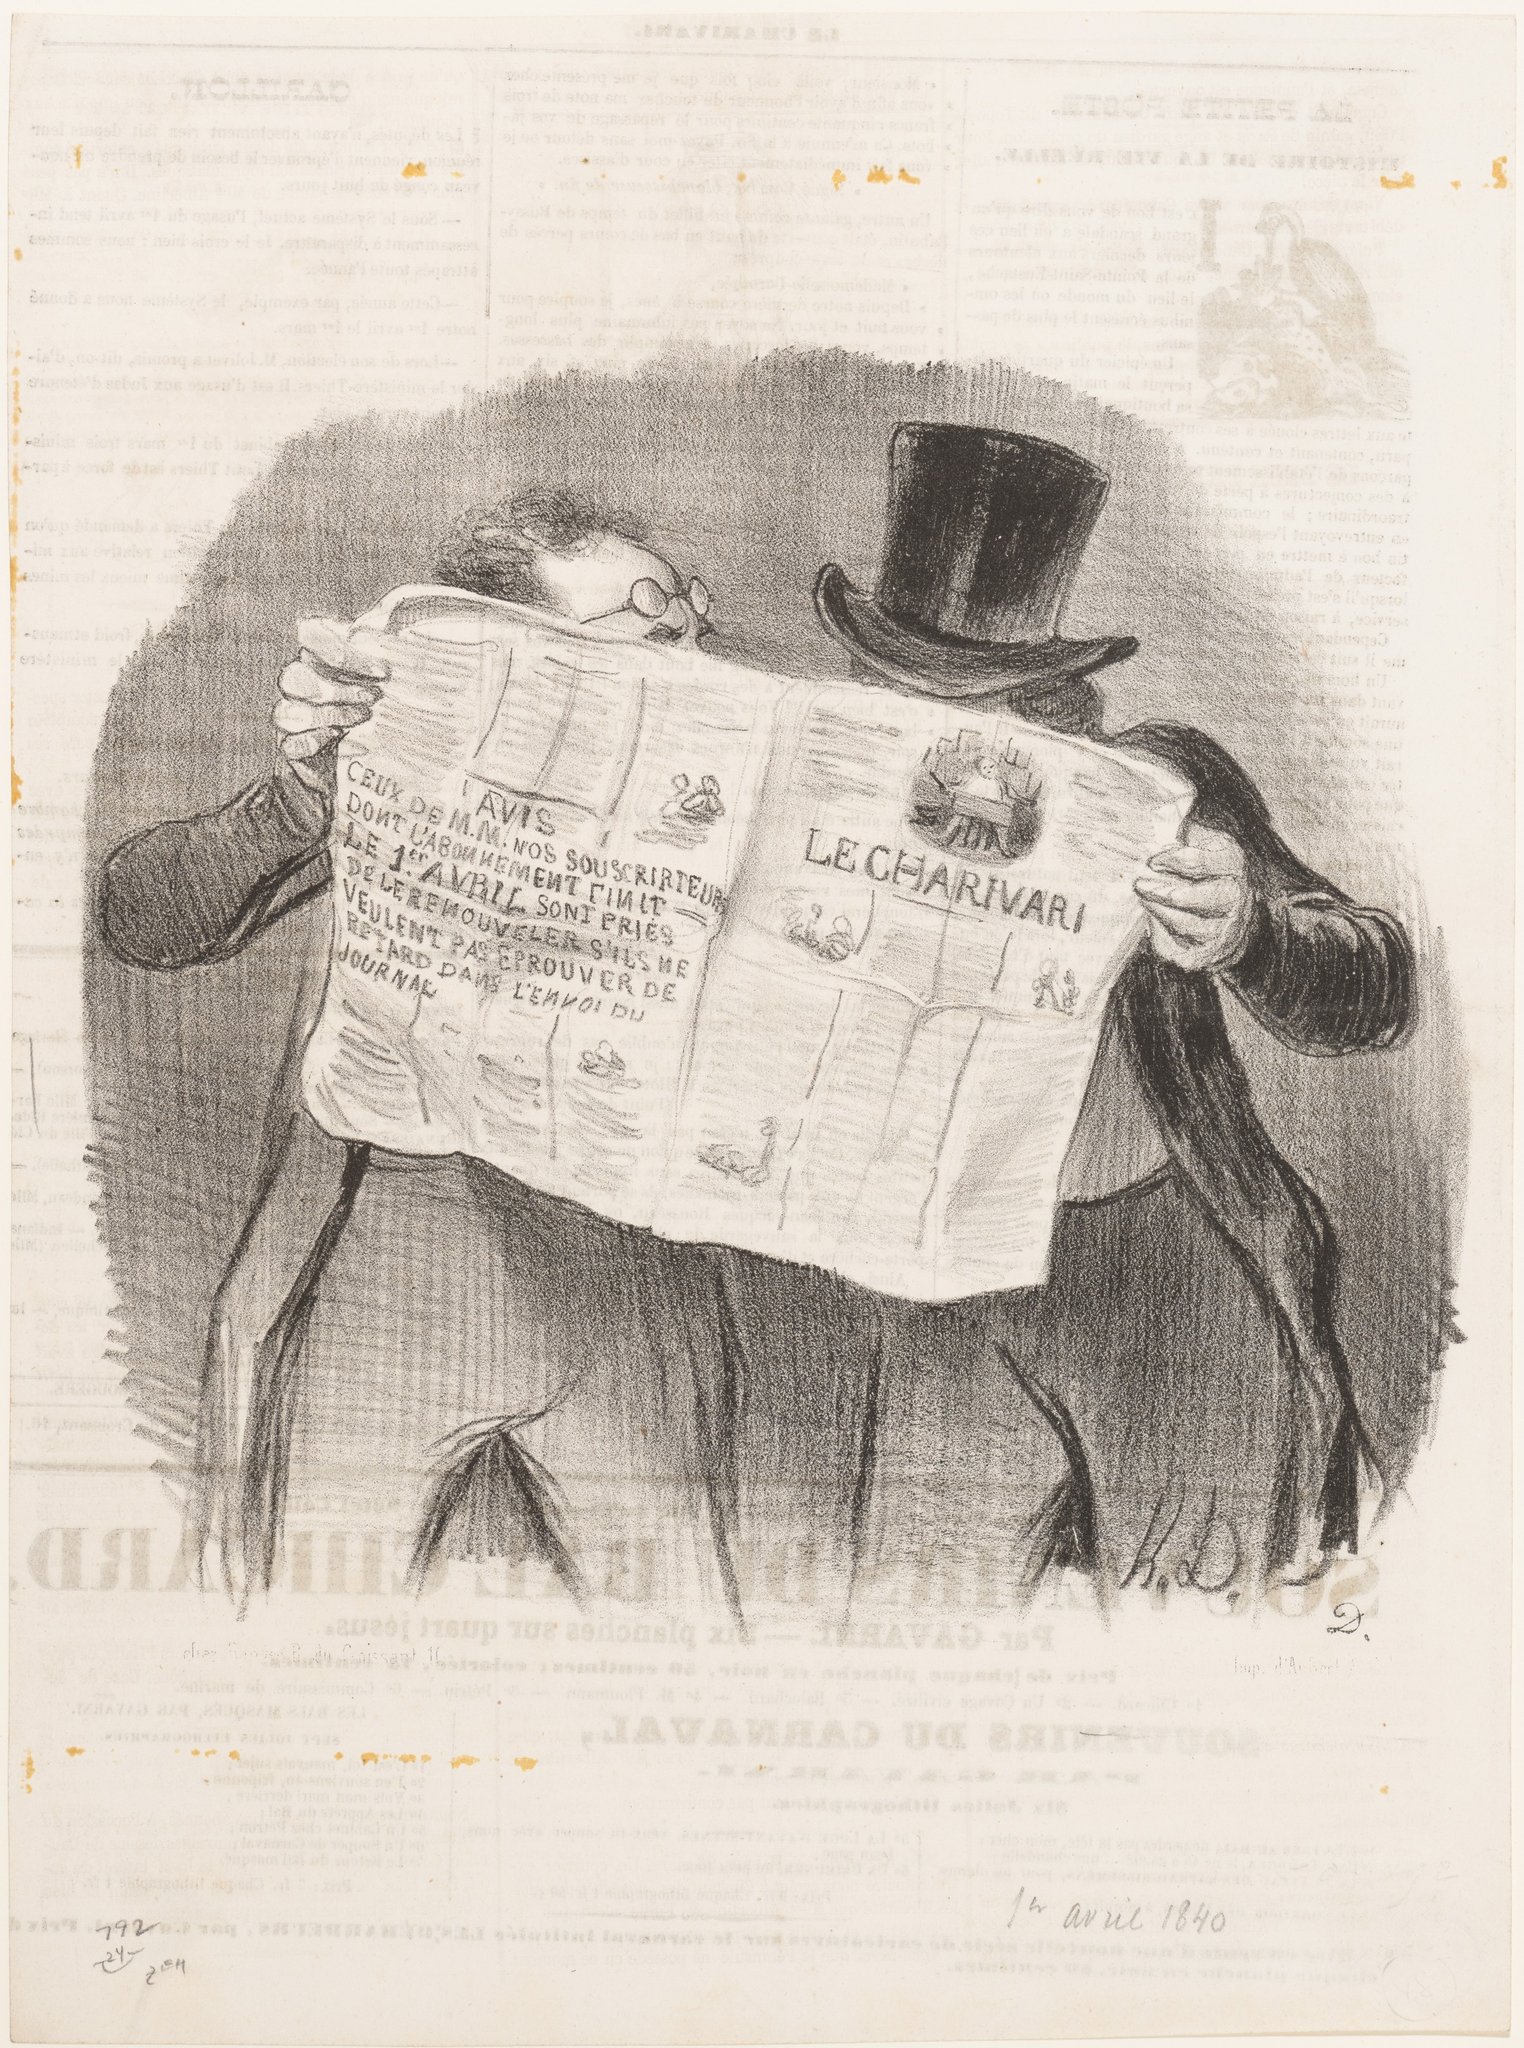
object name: print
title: Advice to Subscribers, published in Le Charivari, April 1, 1840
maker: honoré daumier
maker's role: artist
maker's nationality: french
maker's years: 1808-1879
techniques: lithograph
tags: human figures,reading